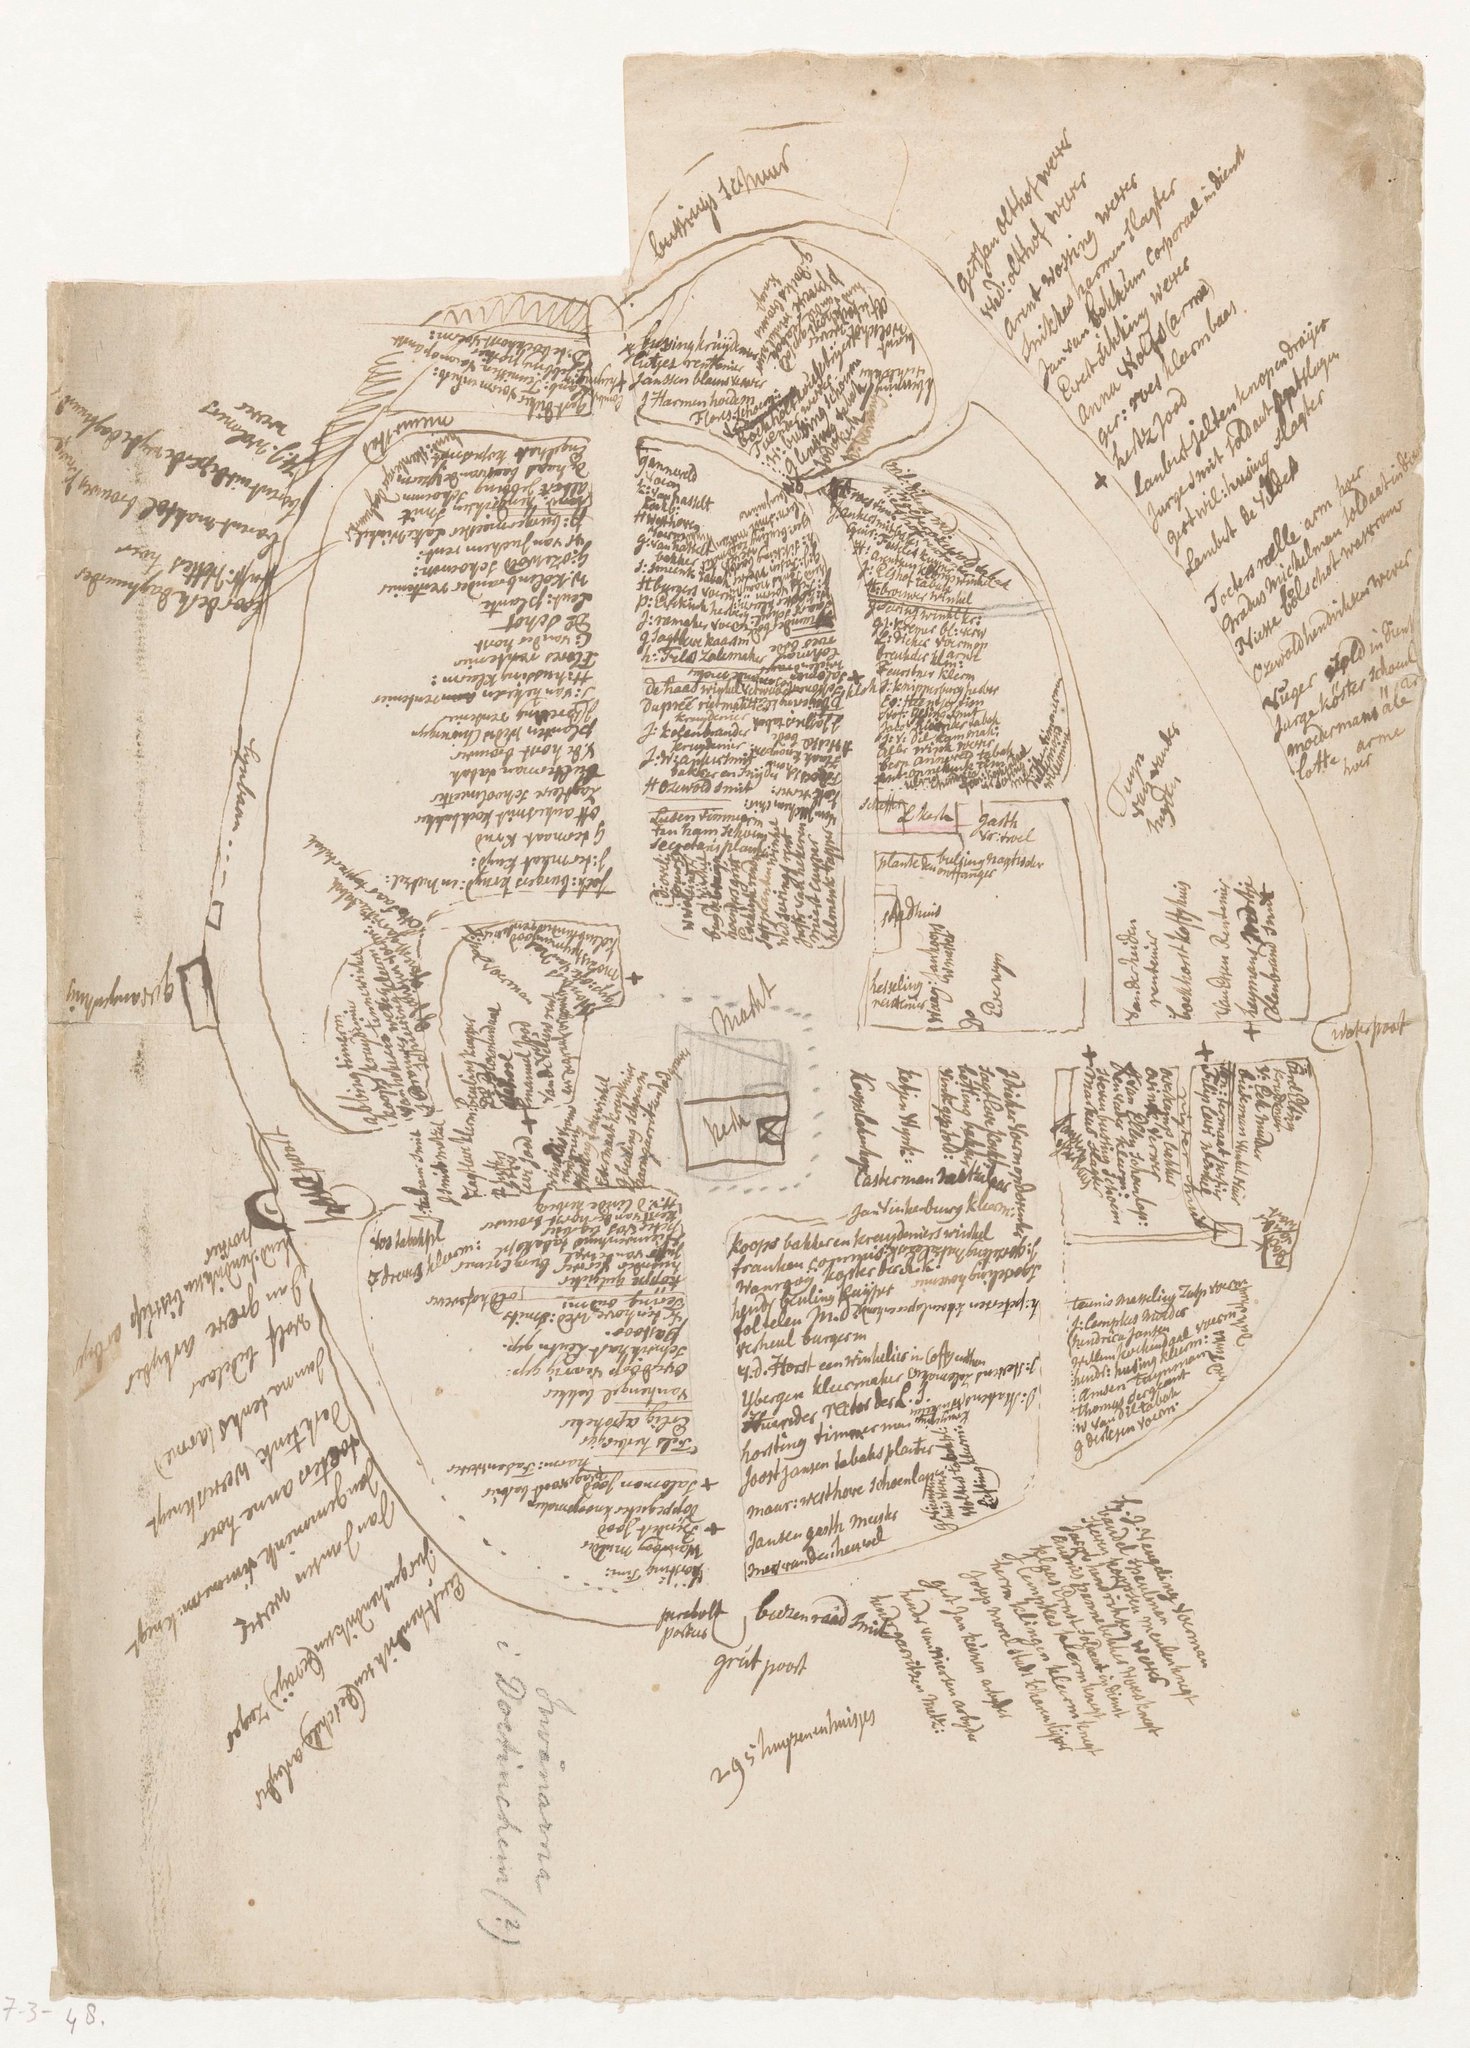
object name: drawing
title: Plattegrond van Doetinchem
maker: jan brandes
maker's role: draughtsman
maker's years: 1743-1808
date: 1770-1778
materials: ink, paper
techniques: pen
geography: doetinchem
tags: maps of cities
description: Plattegrond van Doetinchem. Stadsplan van de stad waar Brandes van 1770 tot 1778 predikant was van de lutherse gemeente. Hij heeft op de plattegrond aangegeven wie (van de lidmaten van zijn gemeente) waar woont. Met opschriften.